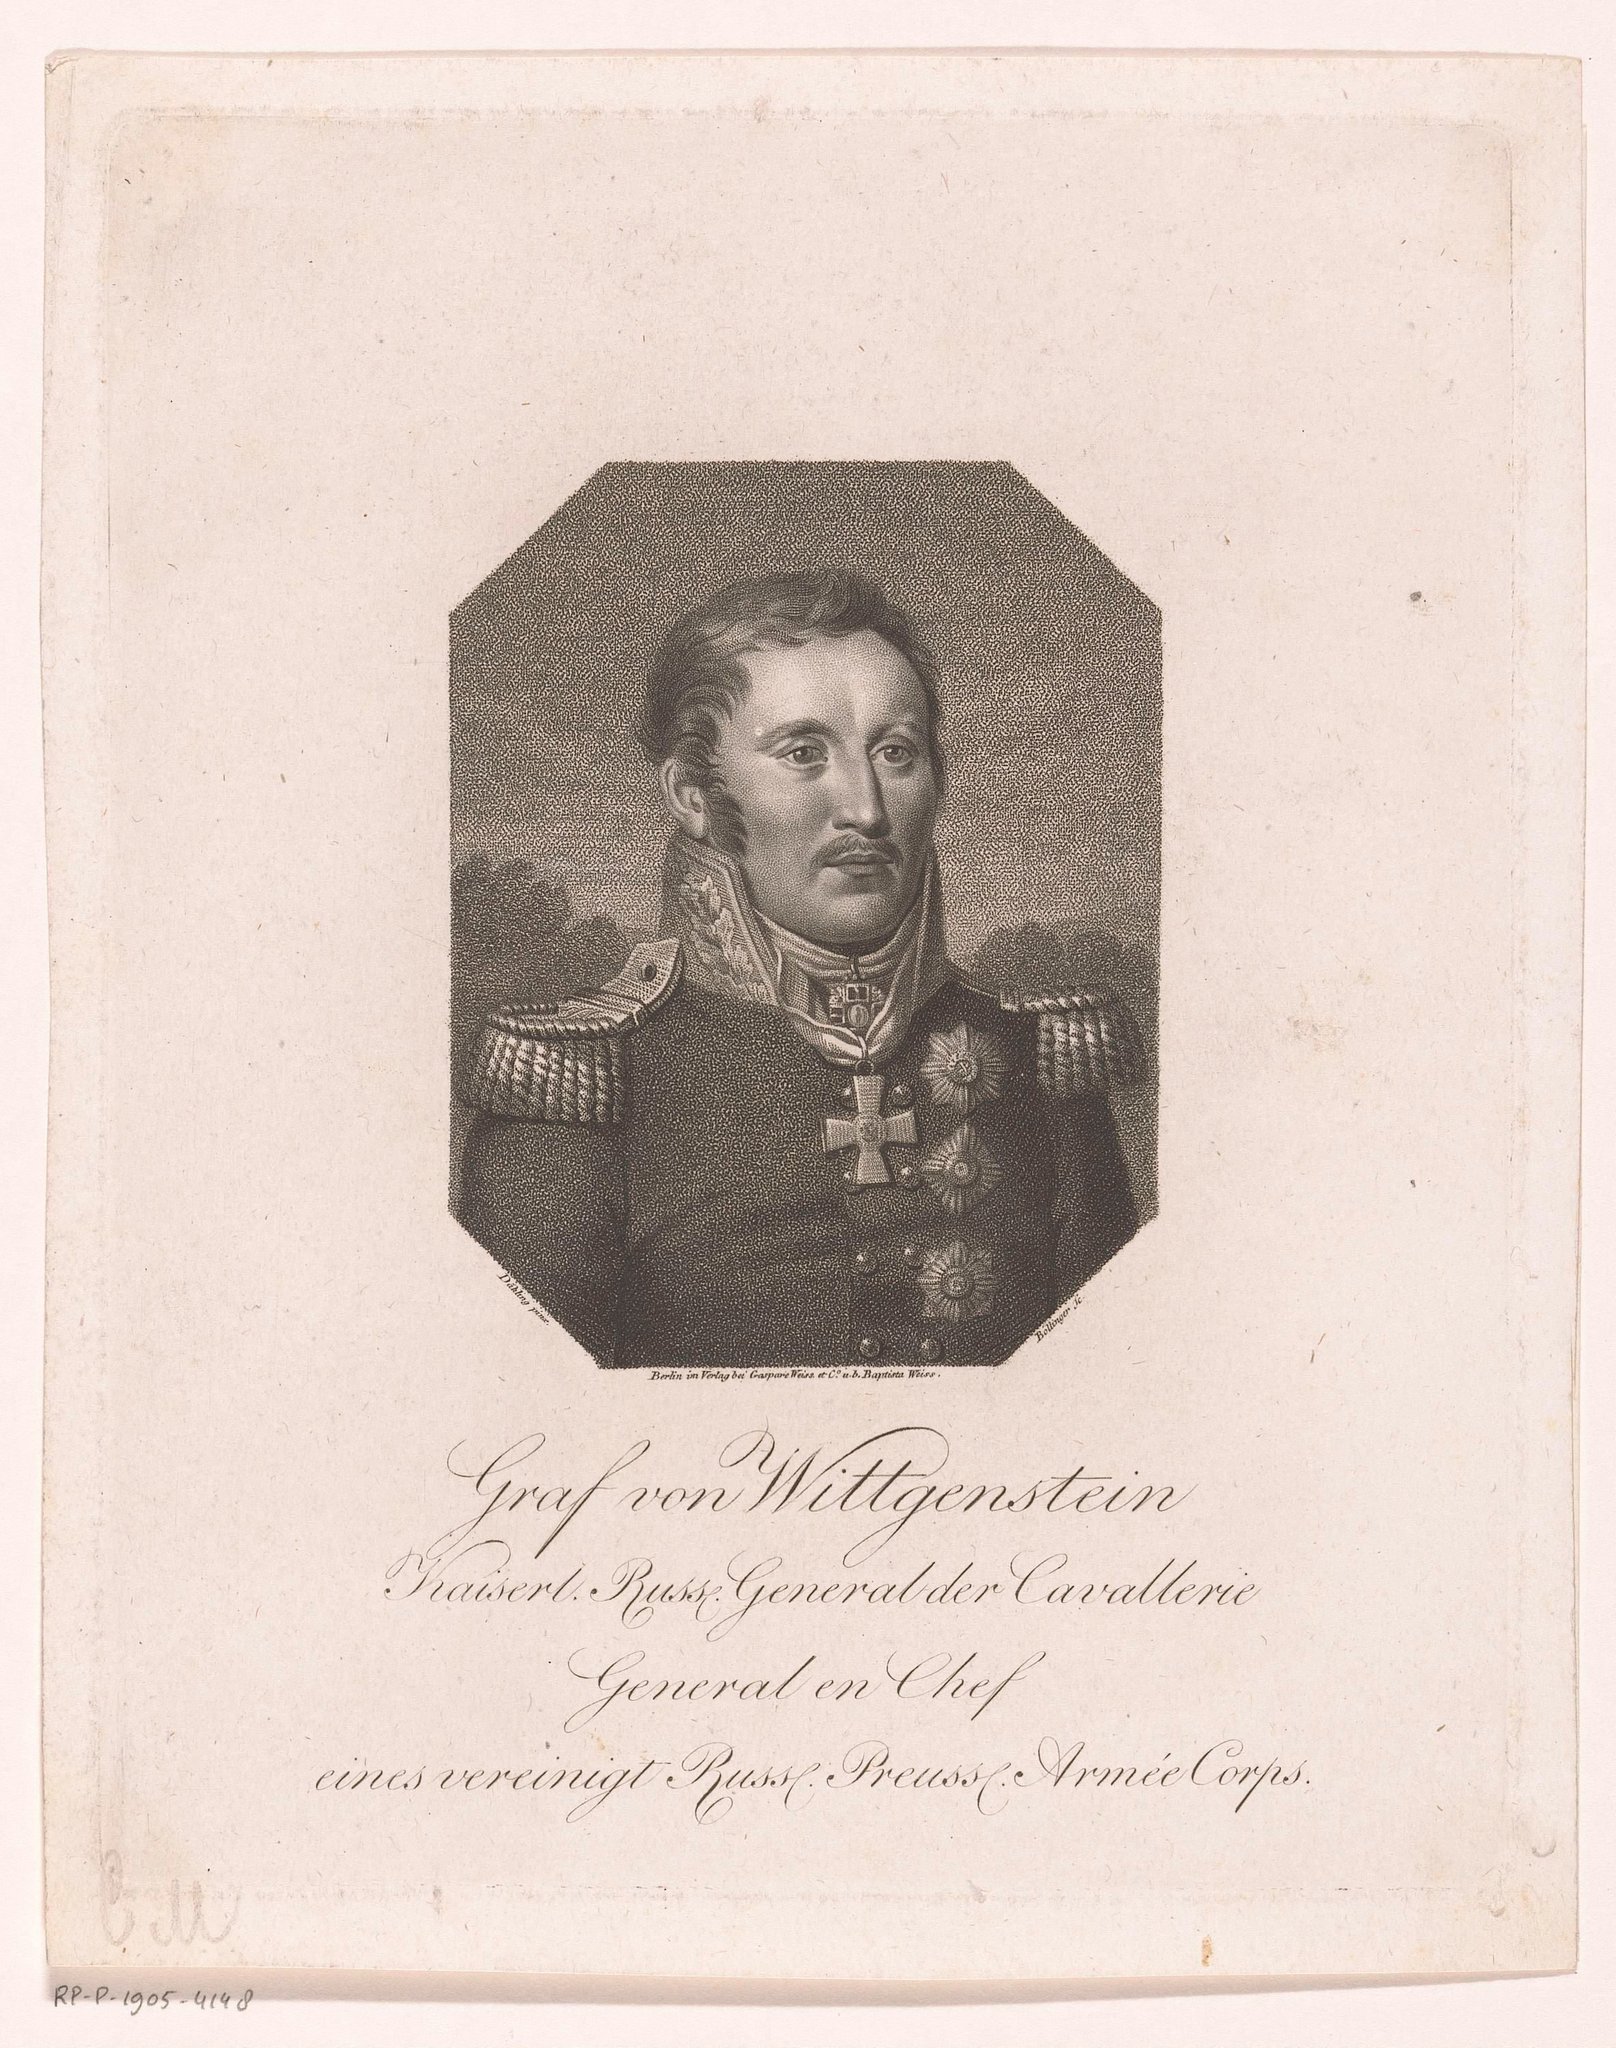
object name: print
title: Portret van Ludwig Adolph Peter, Graf Wittgenstein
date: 1813-1825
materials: paper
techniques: stippling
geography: berlin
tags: knighthood order, historical persons, (military) uniforms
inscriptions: collector's mark: Lugt 2228